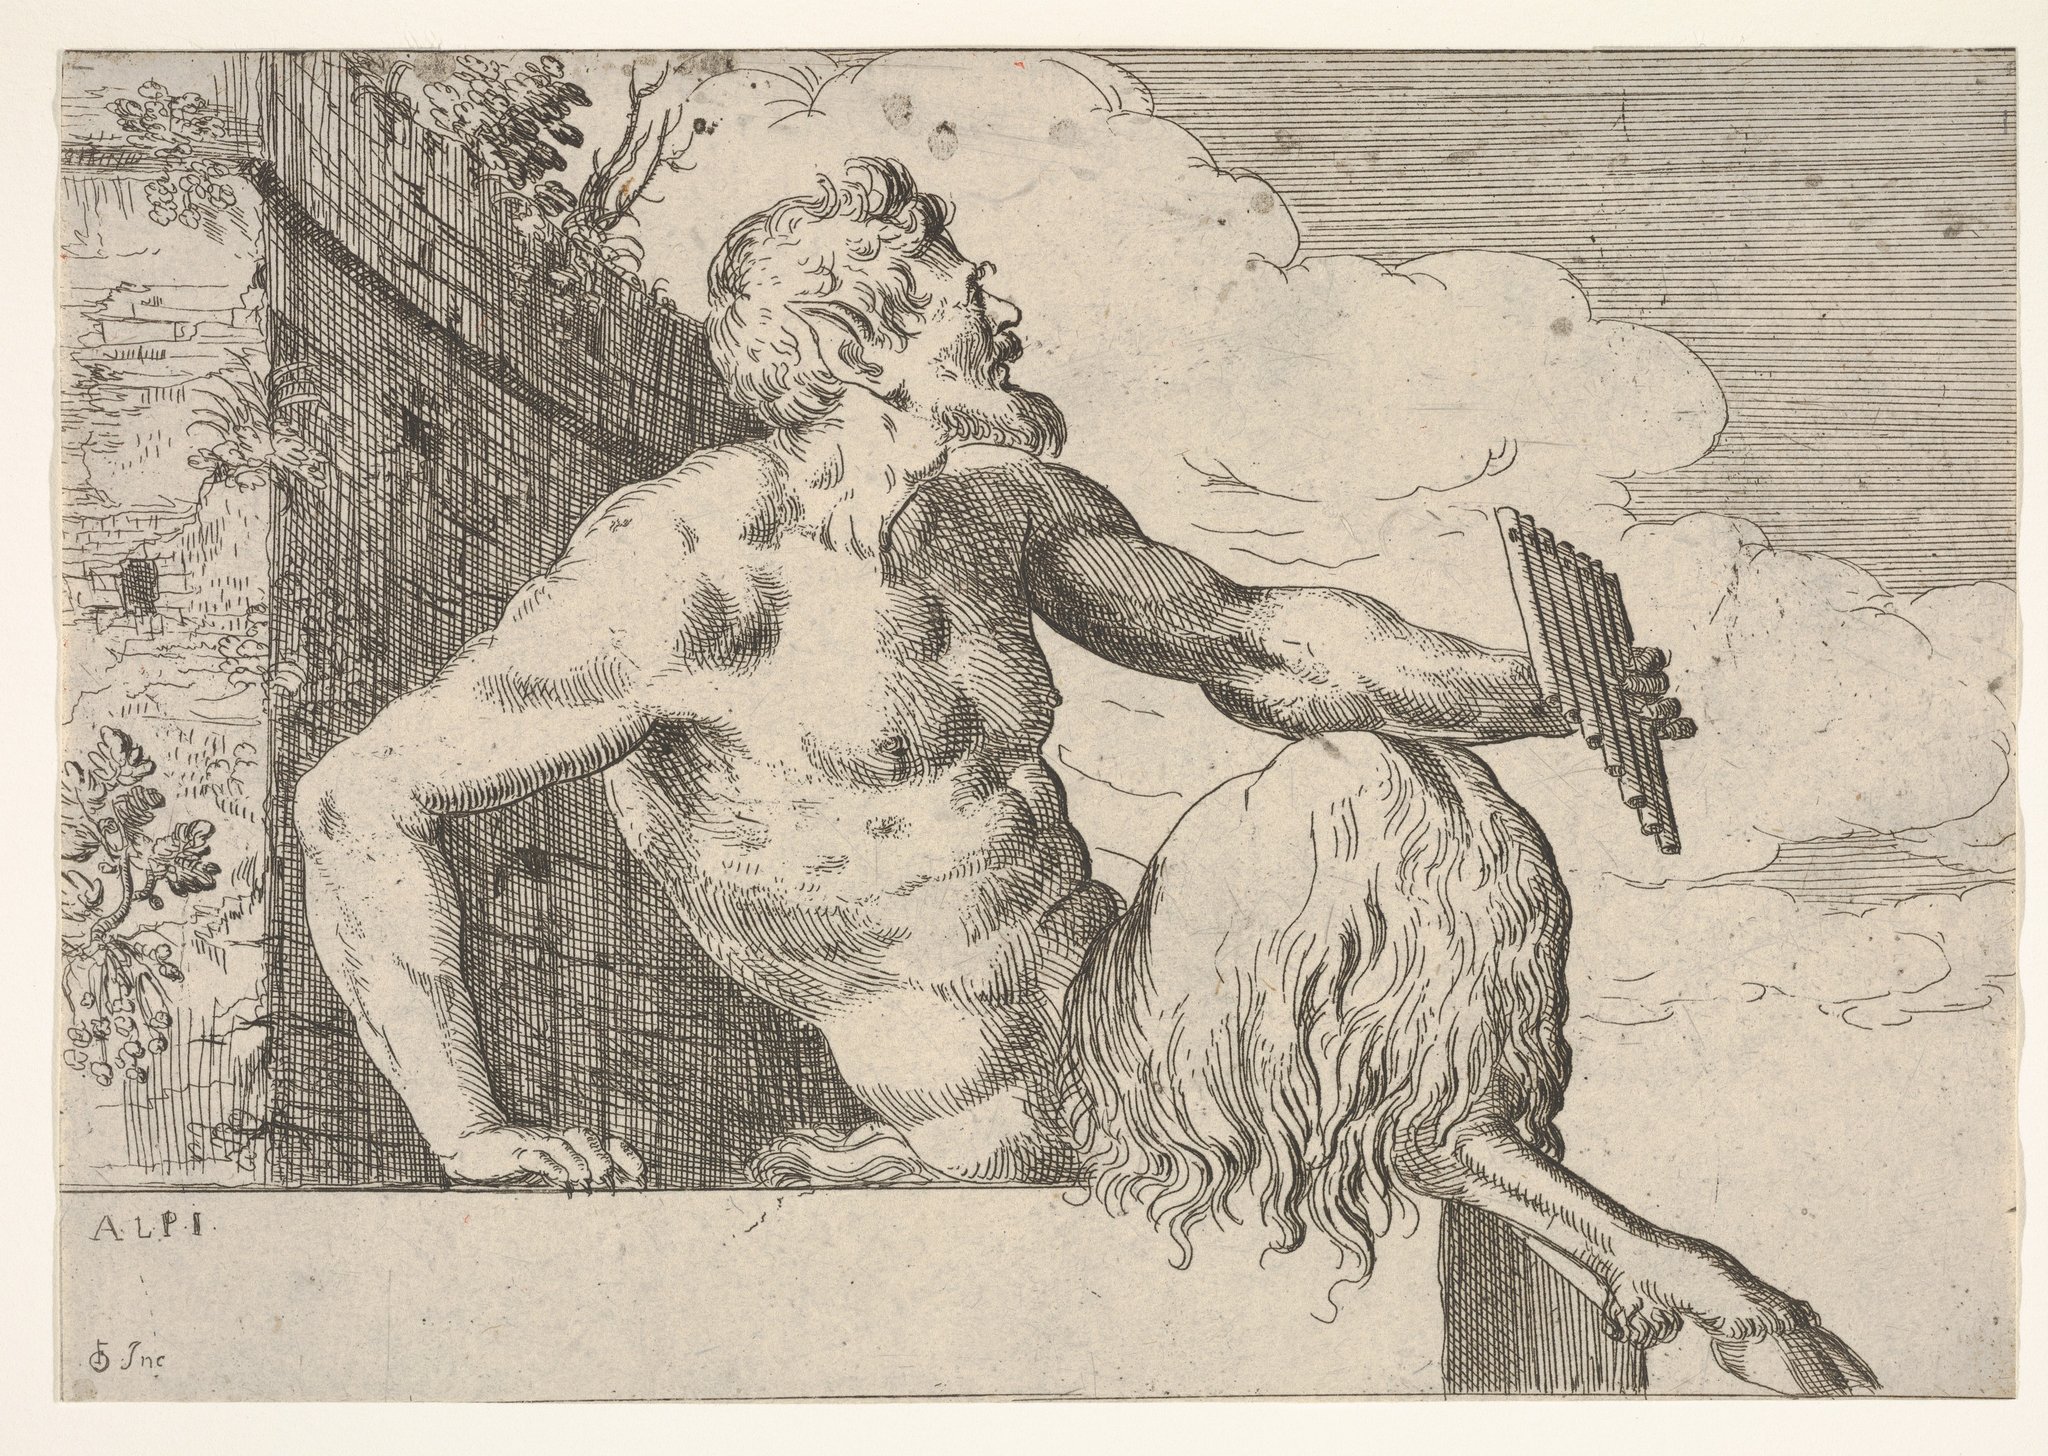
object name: print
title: Seated Pan holding a pipe in his left hand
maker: odoardo fialetti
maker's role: artist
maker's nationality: italian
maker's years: 1573-1638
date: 1600-1630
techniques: etching